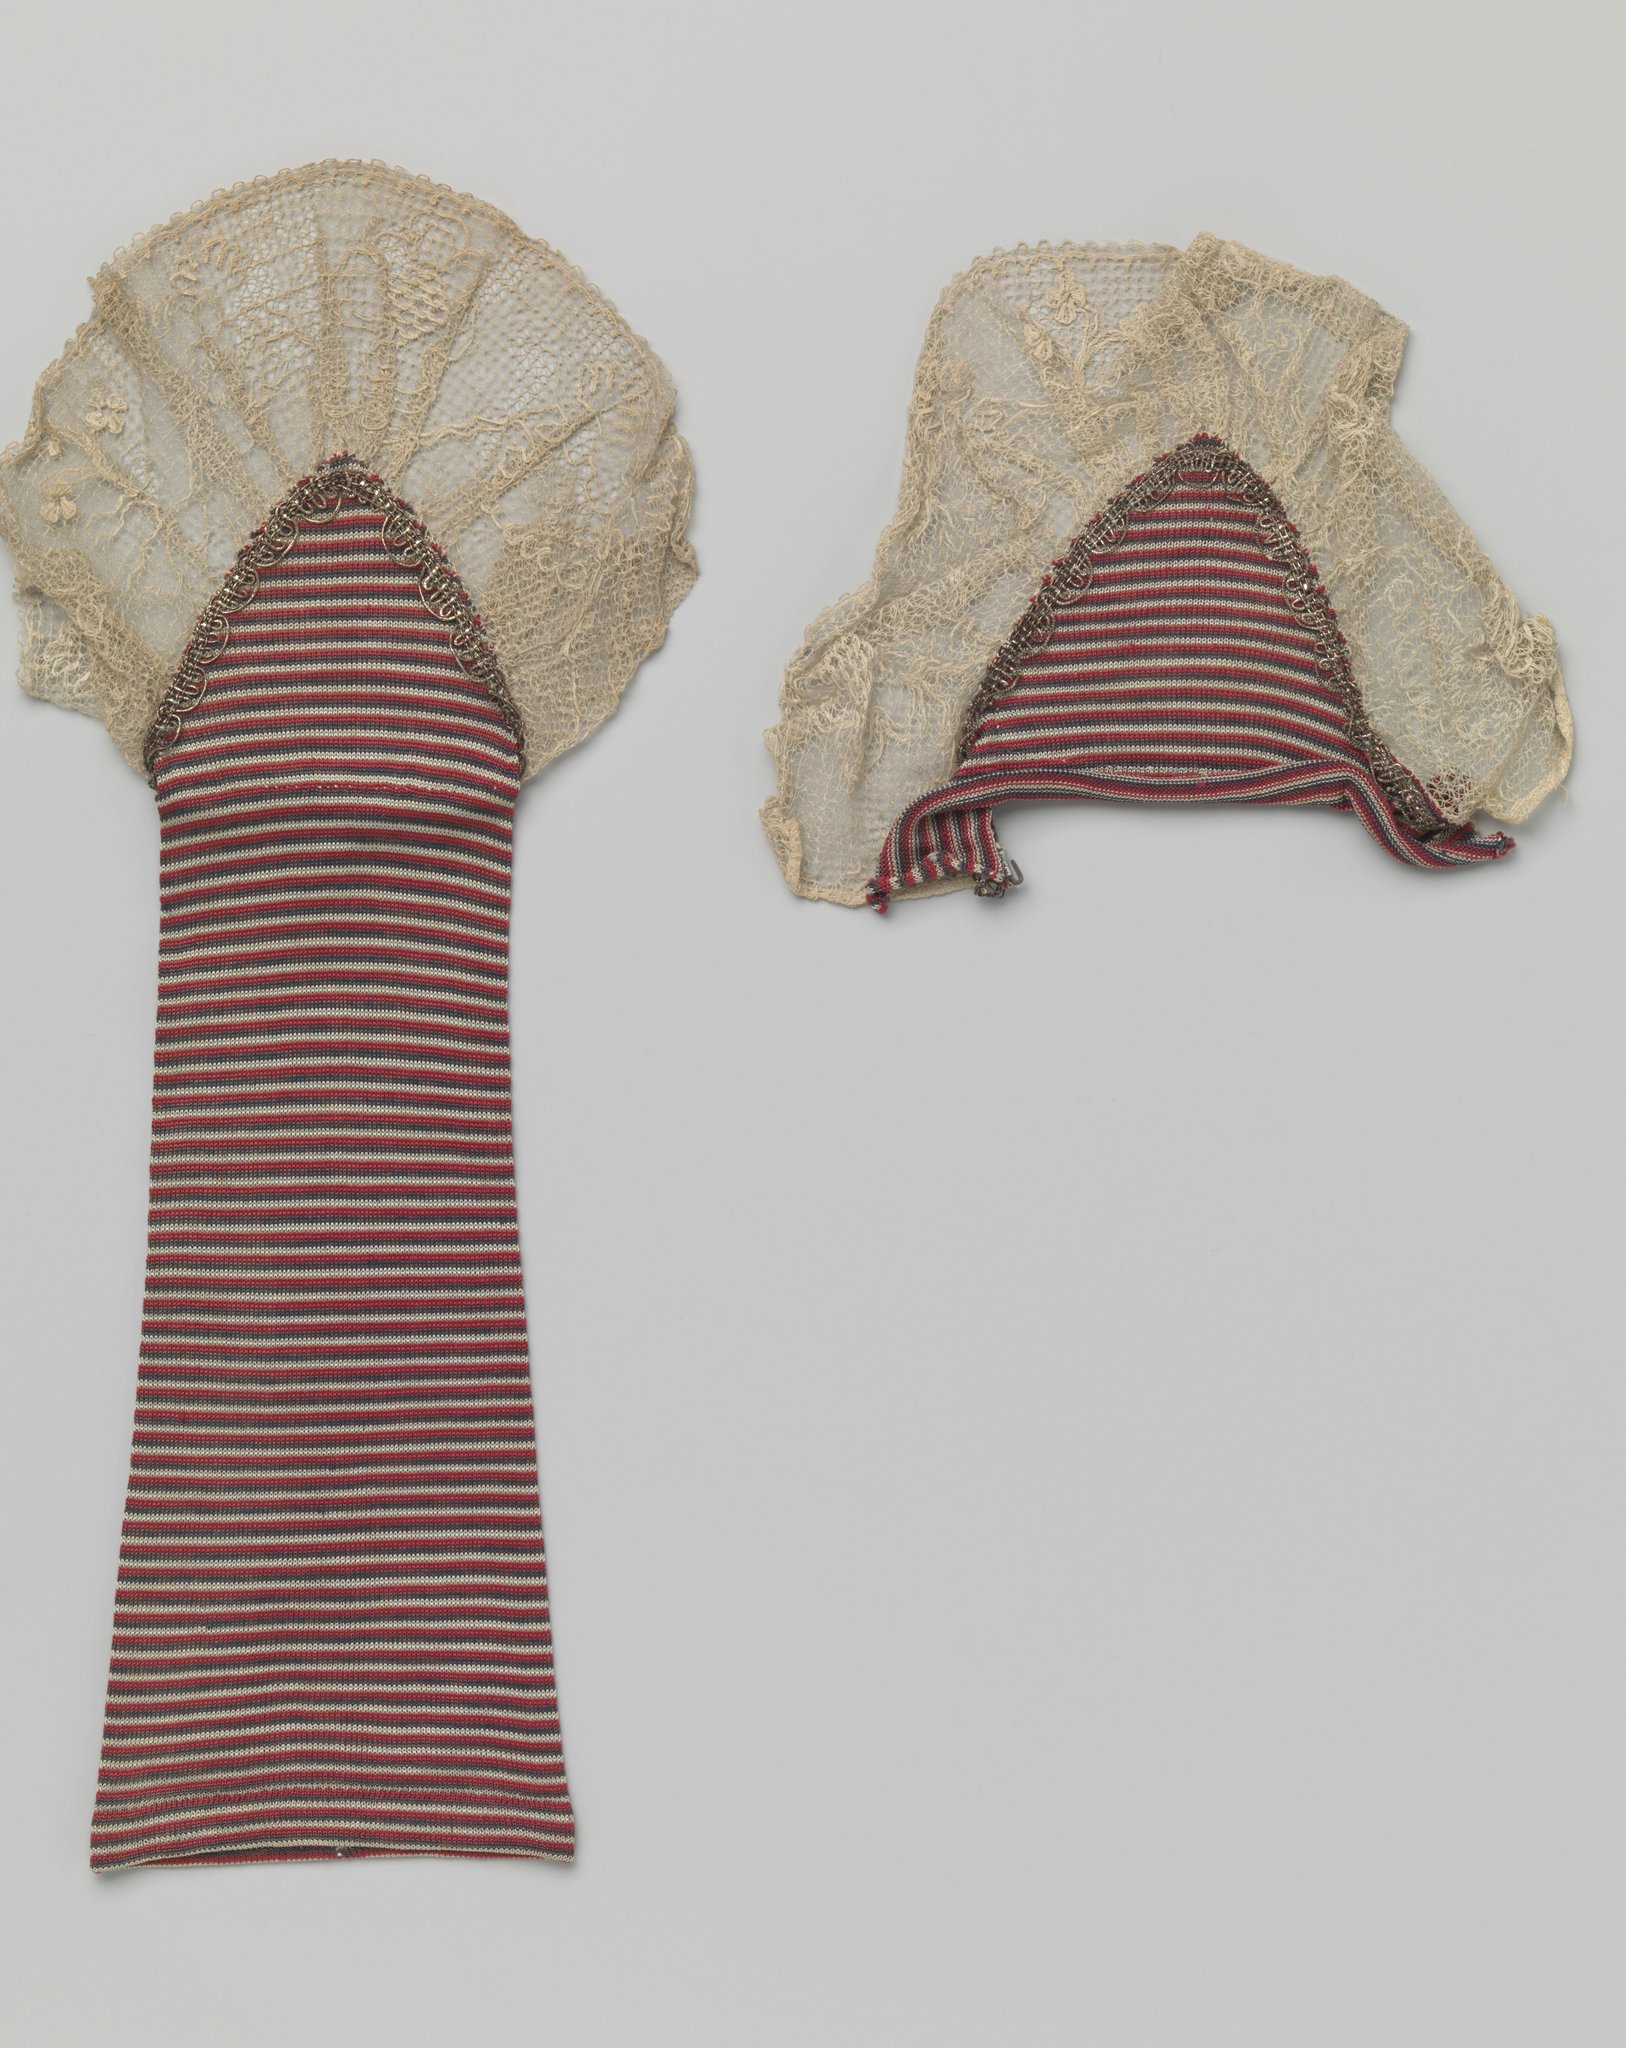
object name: mitt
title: Mitaine van zijde met rode, witte en zwarte strepen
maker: Anonymous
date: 1800-1820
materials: linen, silk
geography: zaanstreek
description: Mitaine van zijde, met rode, witte en zwarte strepen. Afgezet met witte kant en zilvergalon.